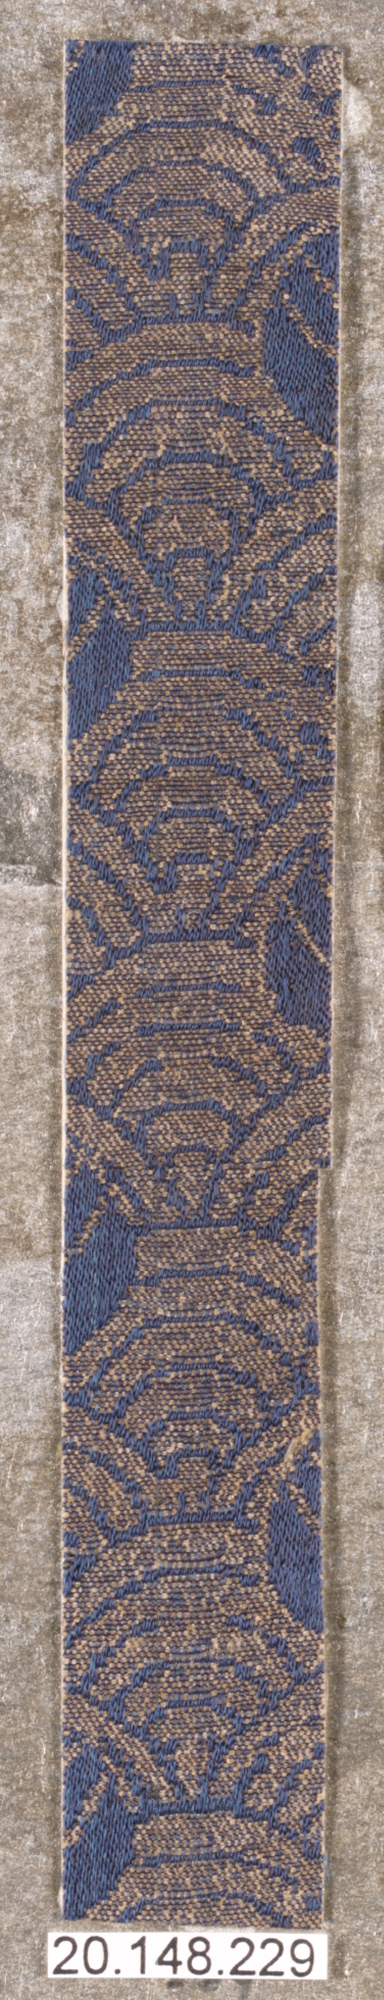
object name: piece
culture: japanese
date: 1701-1800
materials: silk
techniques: compound weave